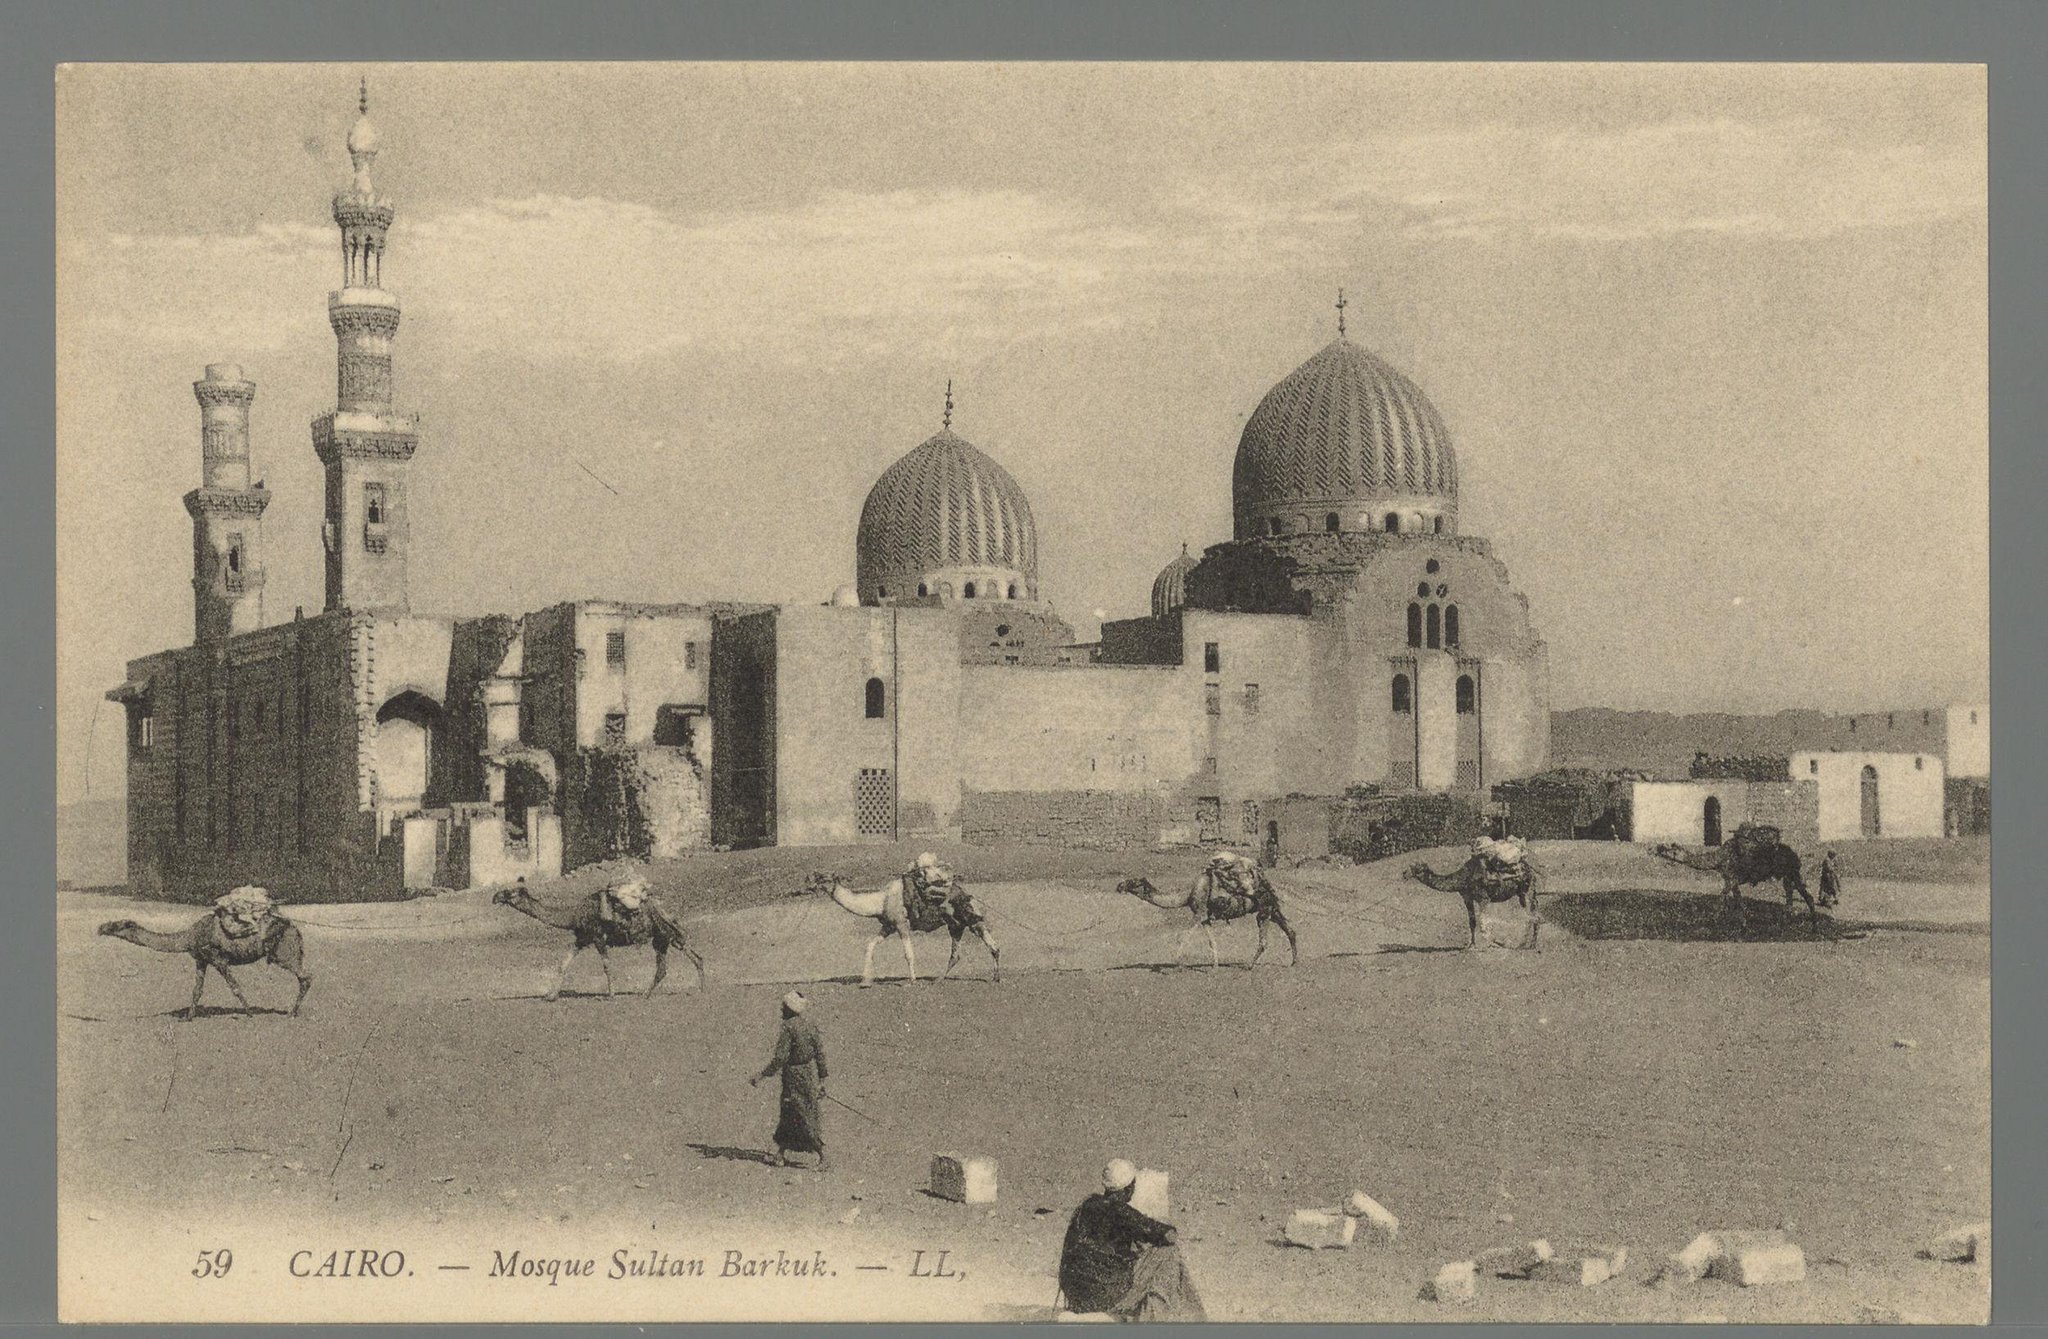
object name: ansichtkaart, prentbriefkaart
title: Cairo - Mosque Sultan Barkuk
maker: Anonymous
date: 1907-1930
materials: cardboard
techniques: photograph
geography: cairo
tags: hoofed animals: camel, temple, shrine ~ islam, mohammedanism